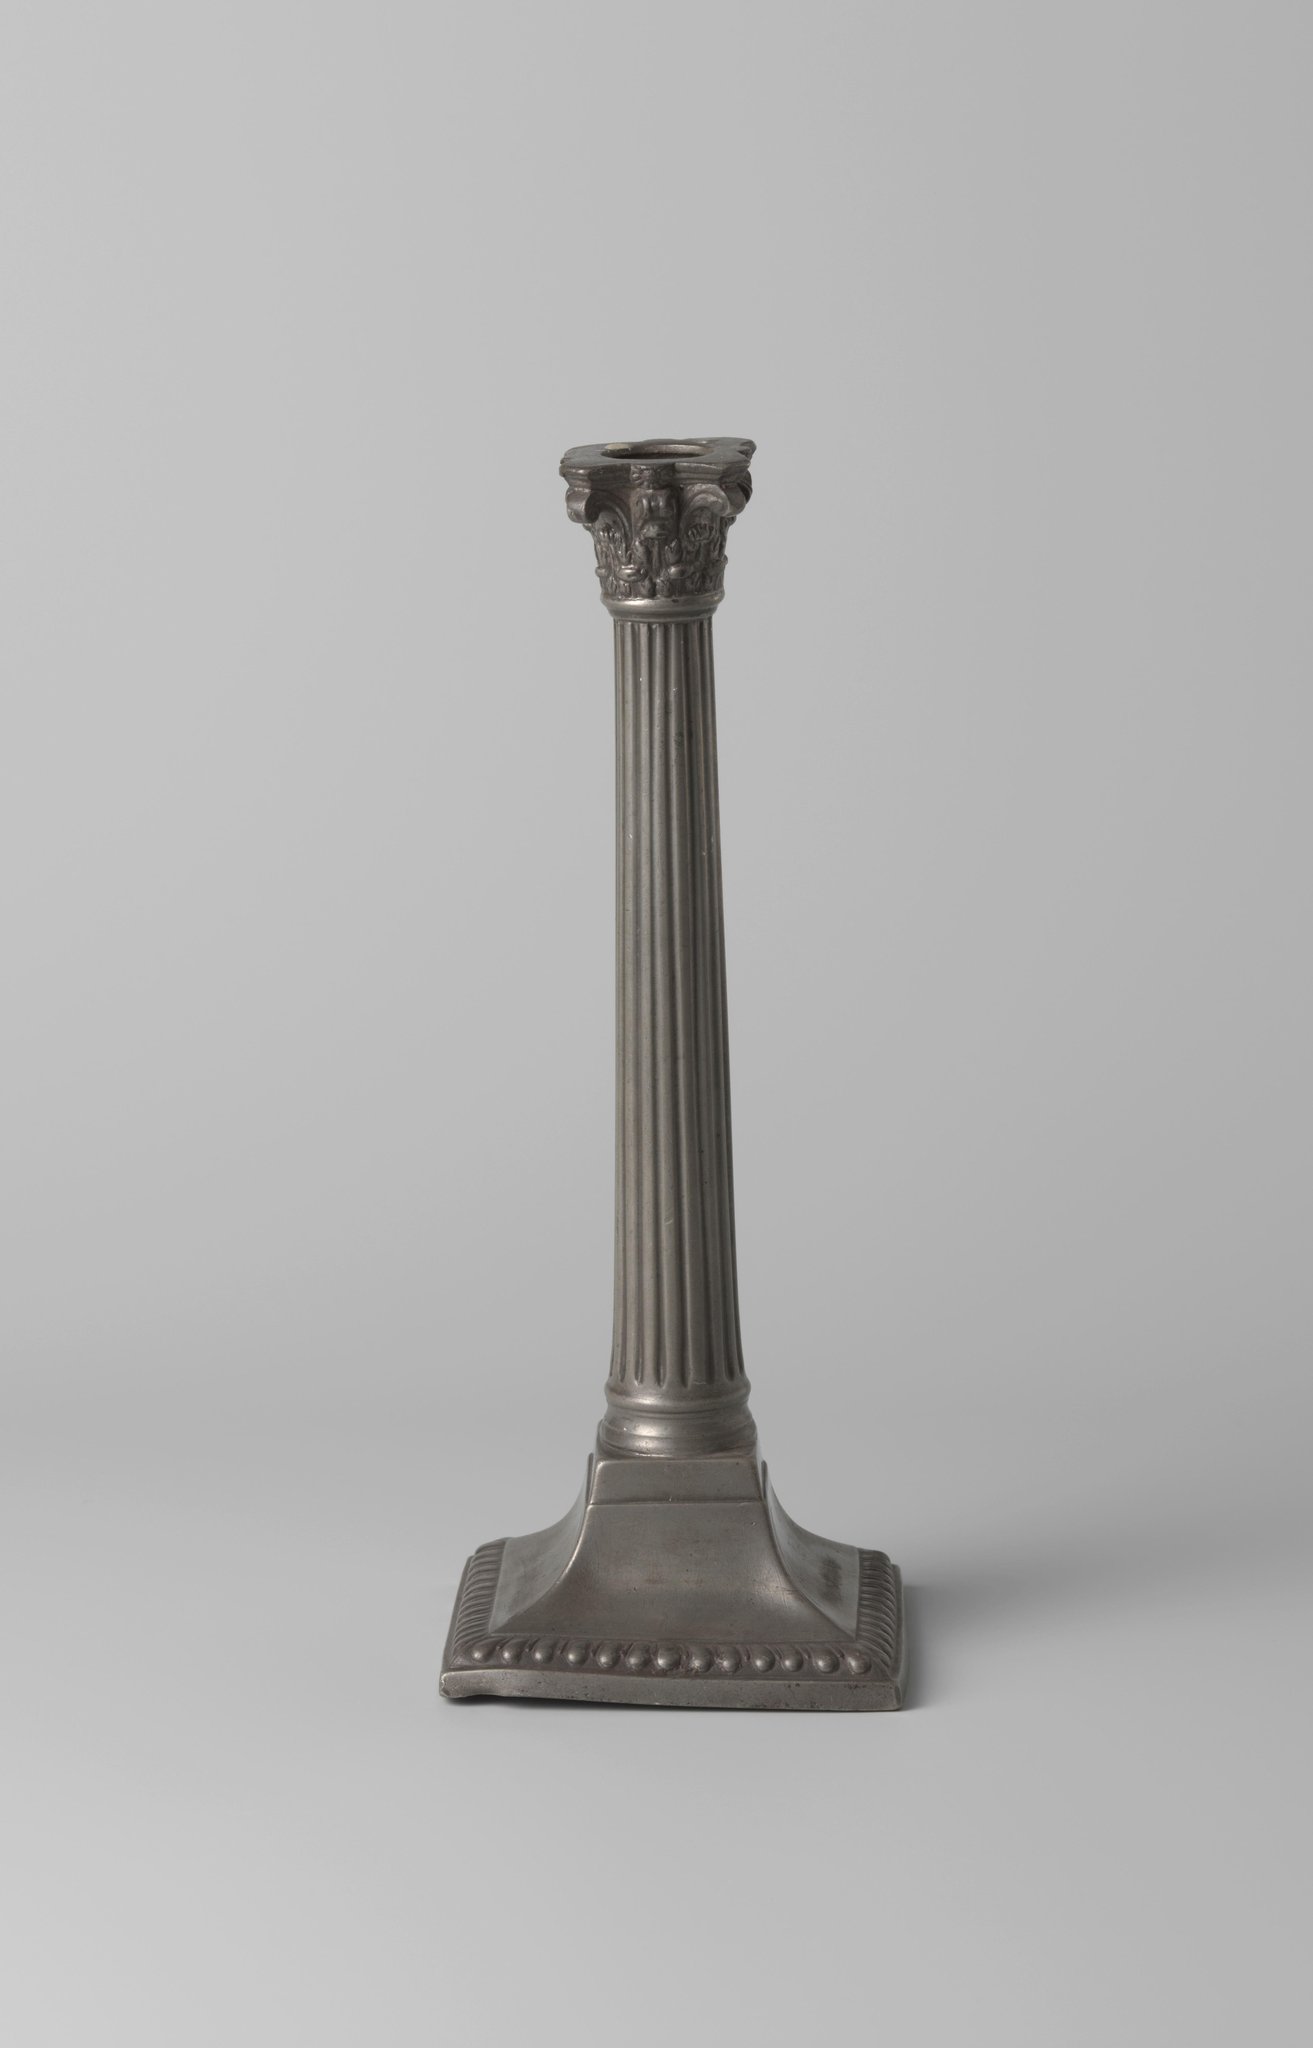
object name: candlestick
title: Kandelaar van tin in de vorm van een Griekse zuil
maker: carel lodewijk schurffius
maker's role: pewterers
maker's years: 1743-1812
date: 1772-1812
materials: tin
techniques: casting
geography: amsterdam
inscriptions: quality mark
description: Kandelaar van tin in de vorm van een Griekse zuil. De vierkante voet is aan de rand voorzien van een eierlijst. Daarboven staat een gecanneleerde stam met de kaarsenhouder in de vorm van een korintisch kapiteel.